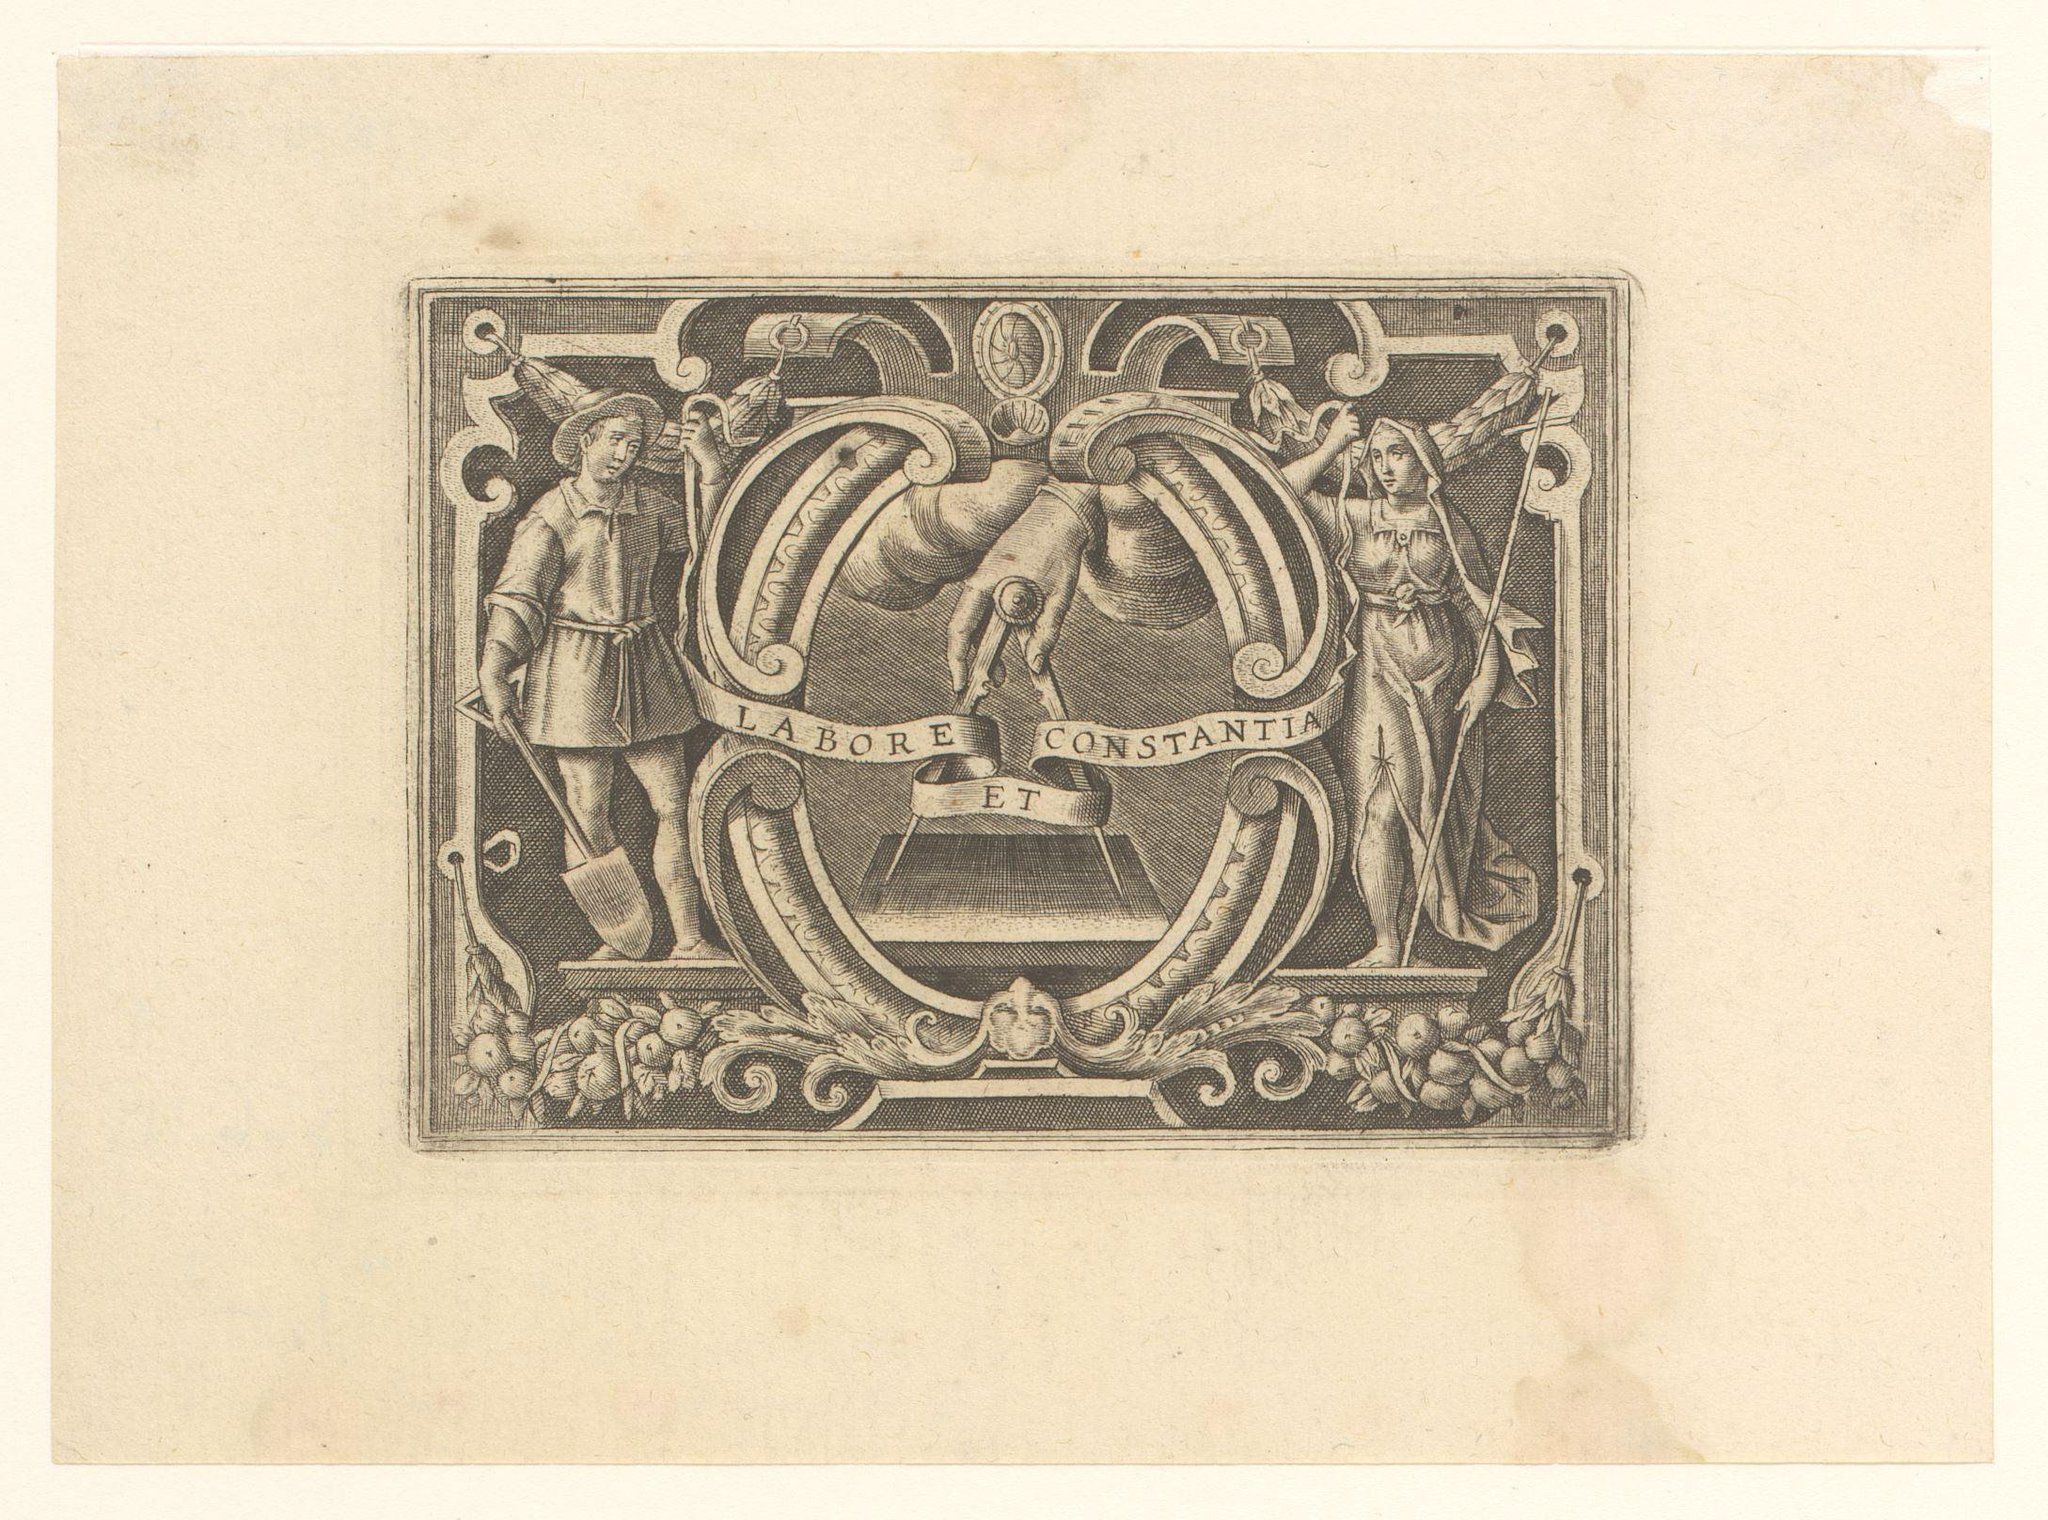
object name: printer's mark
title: Drukkersmerk van Plantijn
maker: Anonymous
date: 1600-1670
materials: paper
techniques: engraving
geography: antwerp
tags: compasses, device (trade-mark of printer or publisher), constancy, tenacity; 'costanza', 'tenacità' (ripa), abstract ideas and concepts (+ personification)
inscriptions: collector's mark: Lugt 2228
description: Drukkersmerk voor de drukkerij Plantijn-Moretus in Antwerpen. In het midden een hand met een passer, een verwijzing naar het uithangbord van de drukkerij 'De gulden passer'. Op een banderol het motto van Christoffel Plantijn: Labore et constantia. Naast het motto staan een mannelijke en vrouwelijke personificatie met schep en crucifix.